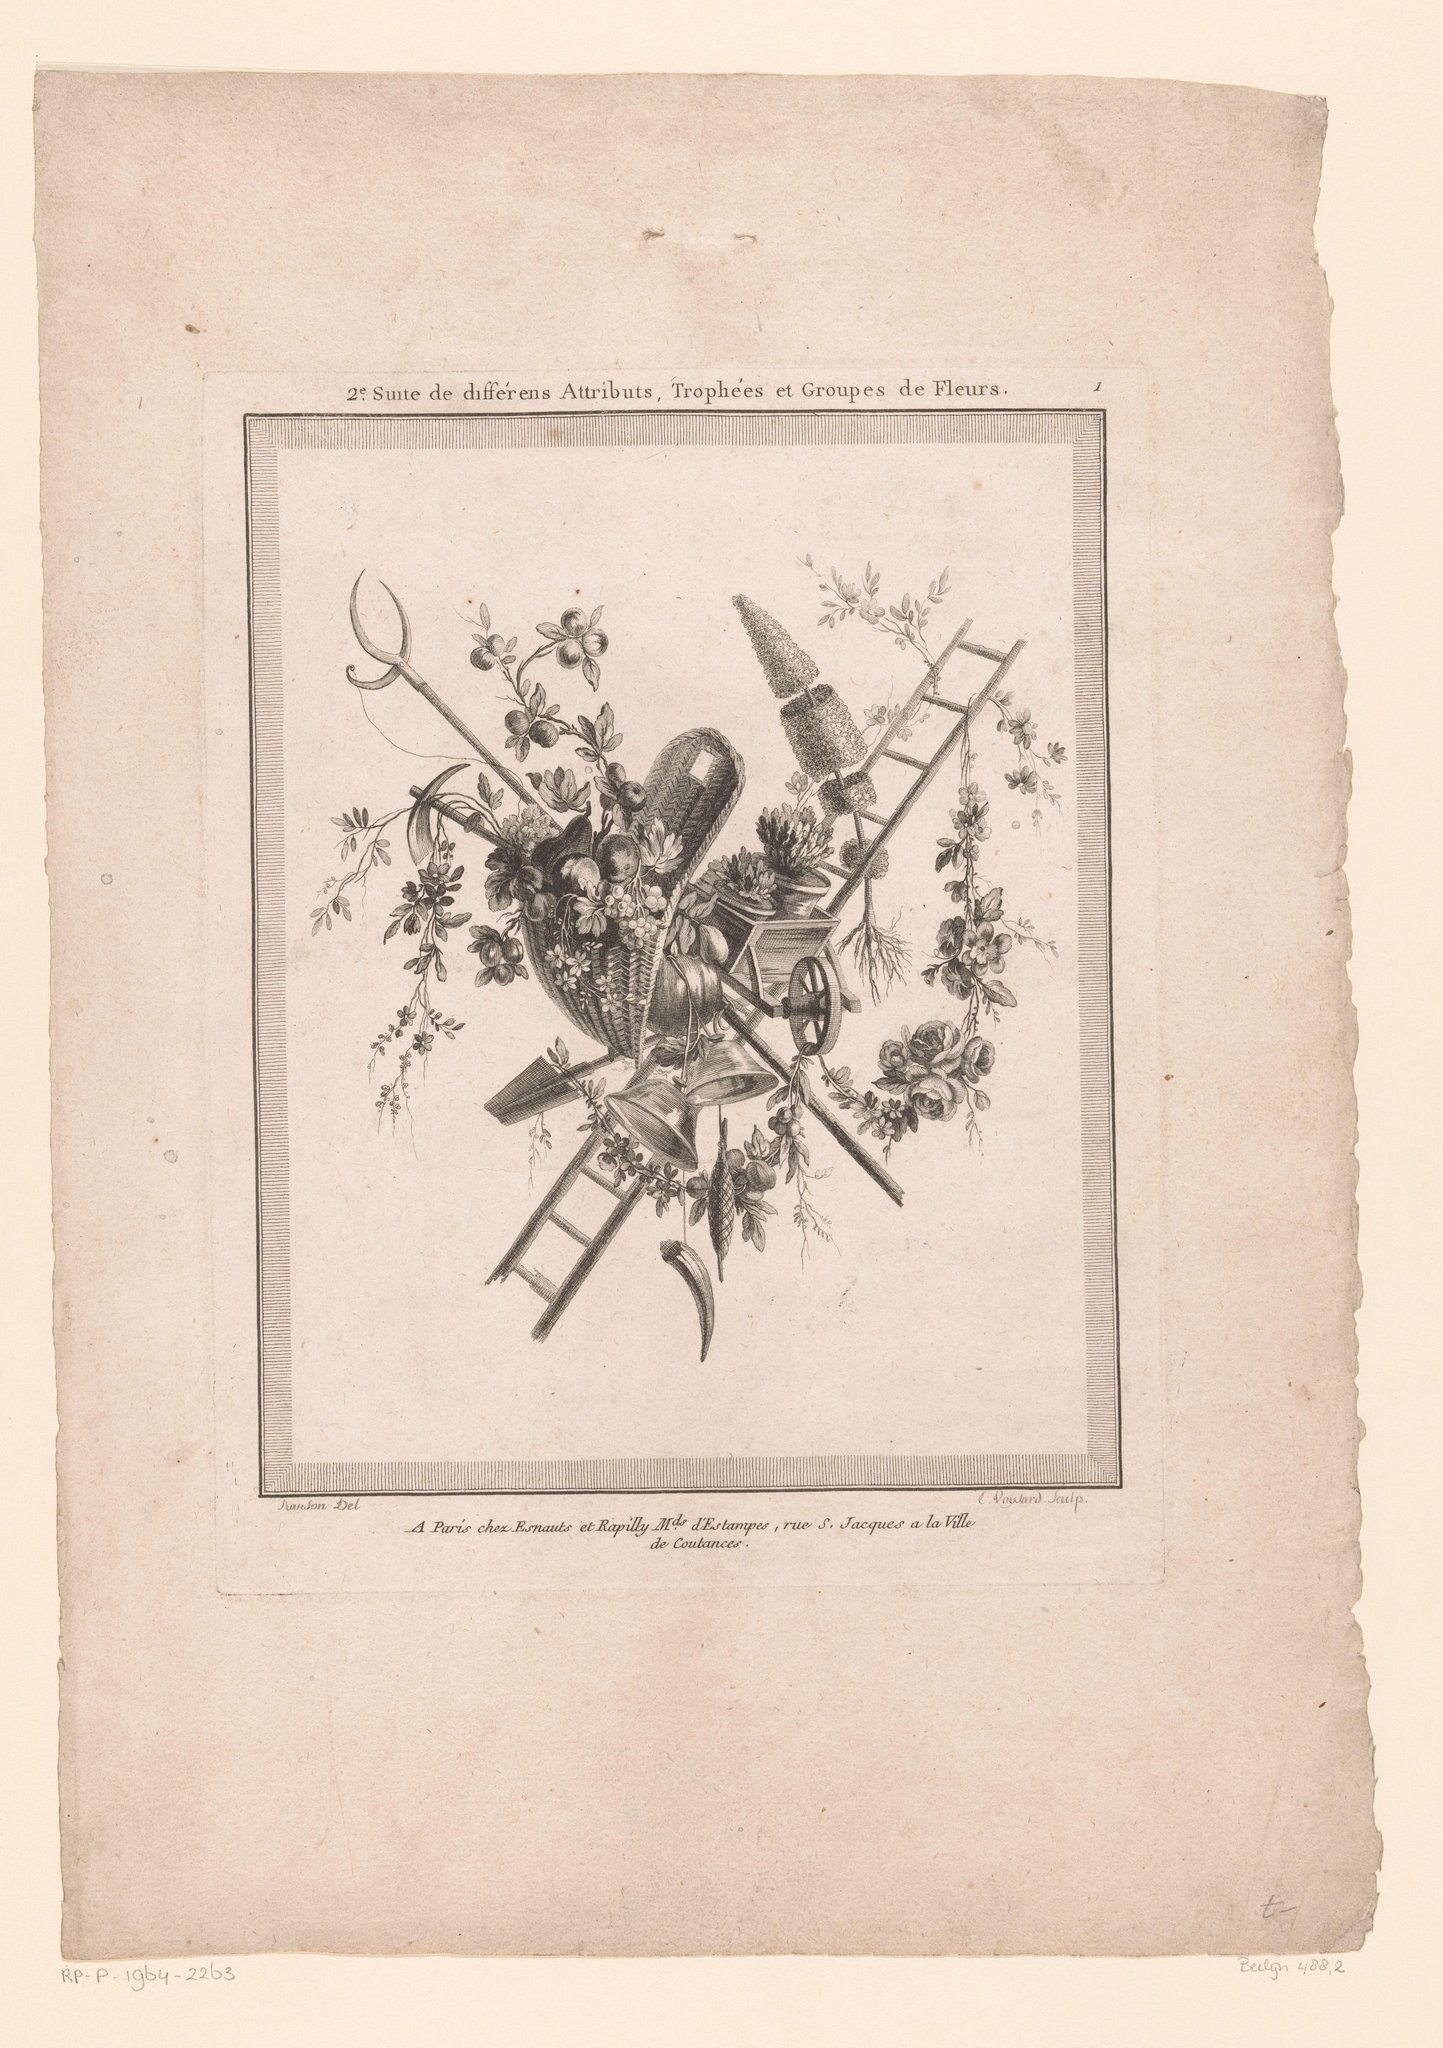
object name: ornament print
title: 2e Suite de différens Attributs, Trophées et Groupes de Fleurs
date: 1778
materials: paper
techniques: etching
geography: paris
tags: trophy, i.e.: decorative arrangement of symbolic or typical objects ~ ornament, gardening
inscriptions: collector's mark: Lugt 2760, collector's mark: Lugt 2228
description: Een trofee met objecten behorend bij tuinbouw zoals een houweel, een schep, een ladder, een kruiwagen en planten.